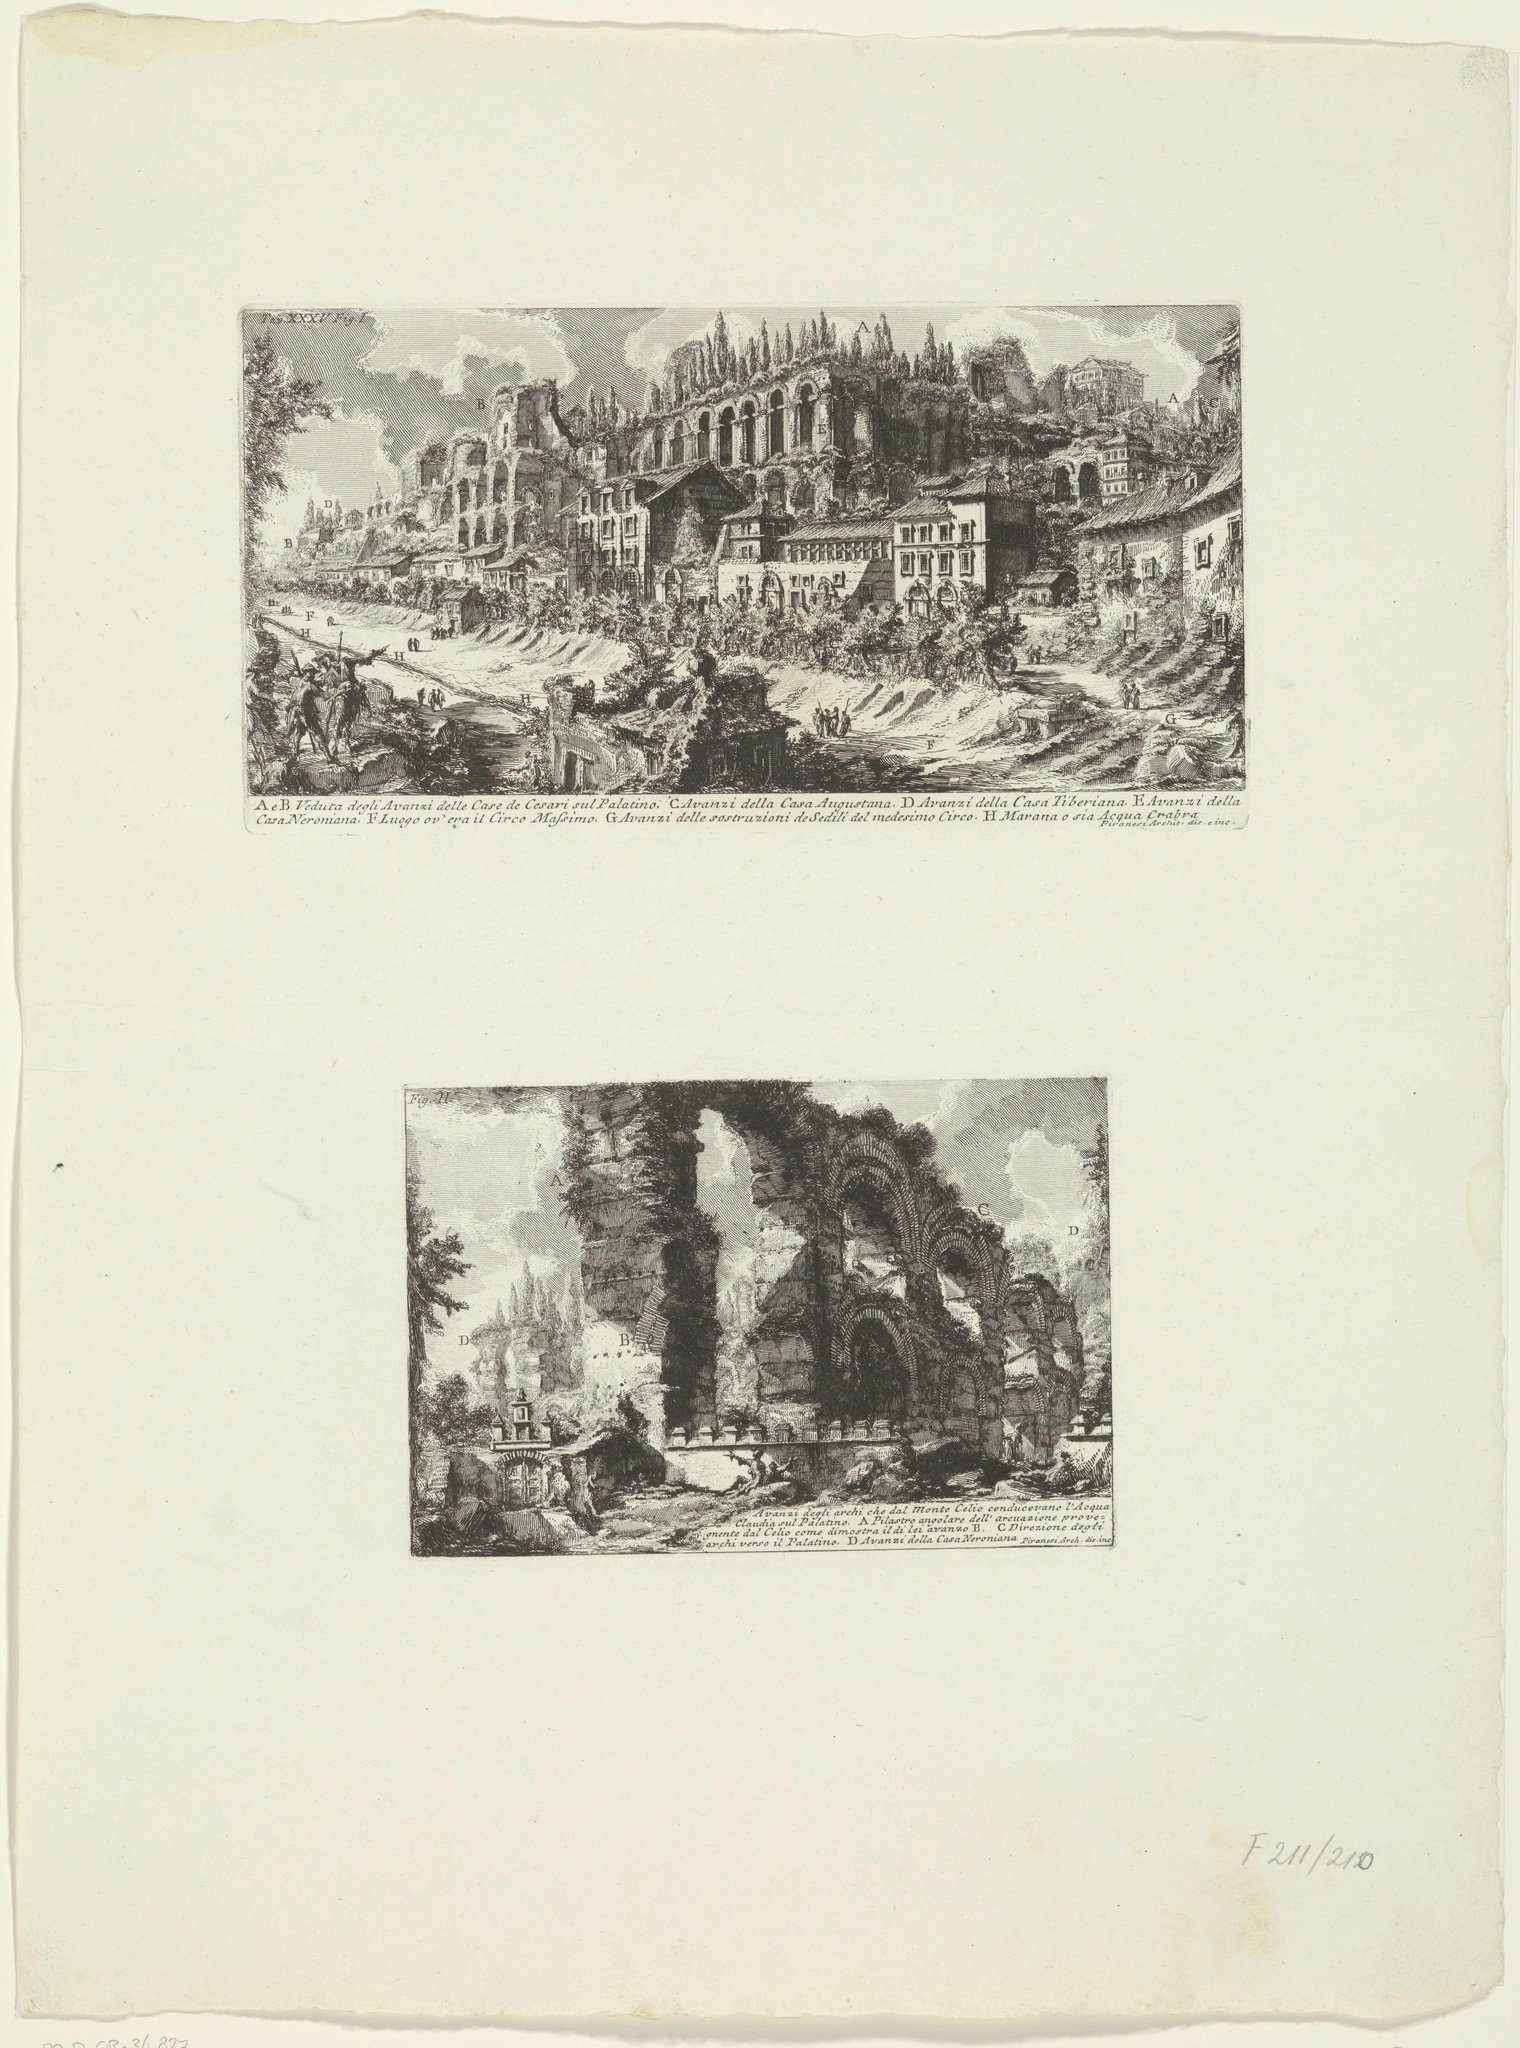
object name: print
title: Avanzi degli archi che dal Monte Celio conducevano l'Acqua Claudia sul Palatino (onder)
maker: giovanni battista piranesi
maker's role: designer, draughtsman, print maker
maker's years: 1720-1778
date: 1756-1757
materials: paper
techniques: etching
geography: rome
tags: ruin of a building ~ architecture, aqueduct (~ water supply)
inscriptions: collector's mark: Lugt 2228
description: Blad met twee voorstellingen van Romeinse bouwwerken. Boven: gezicht op de restanten van de keizerlijke paleizen op de heuvel Palatijn. Genummerd linksboven: Tav. XXXV Fig. I. Verklarende lijst met letters in ondermarge. Onder: restanten van het aquaduct Aqua Claudia. Genummerd linksboven: Fig. II. Titel en verklarende lijst met letters in ondermarge.